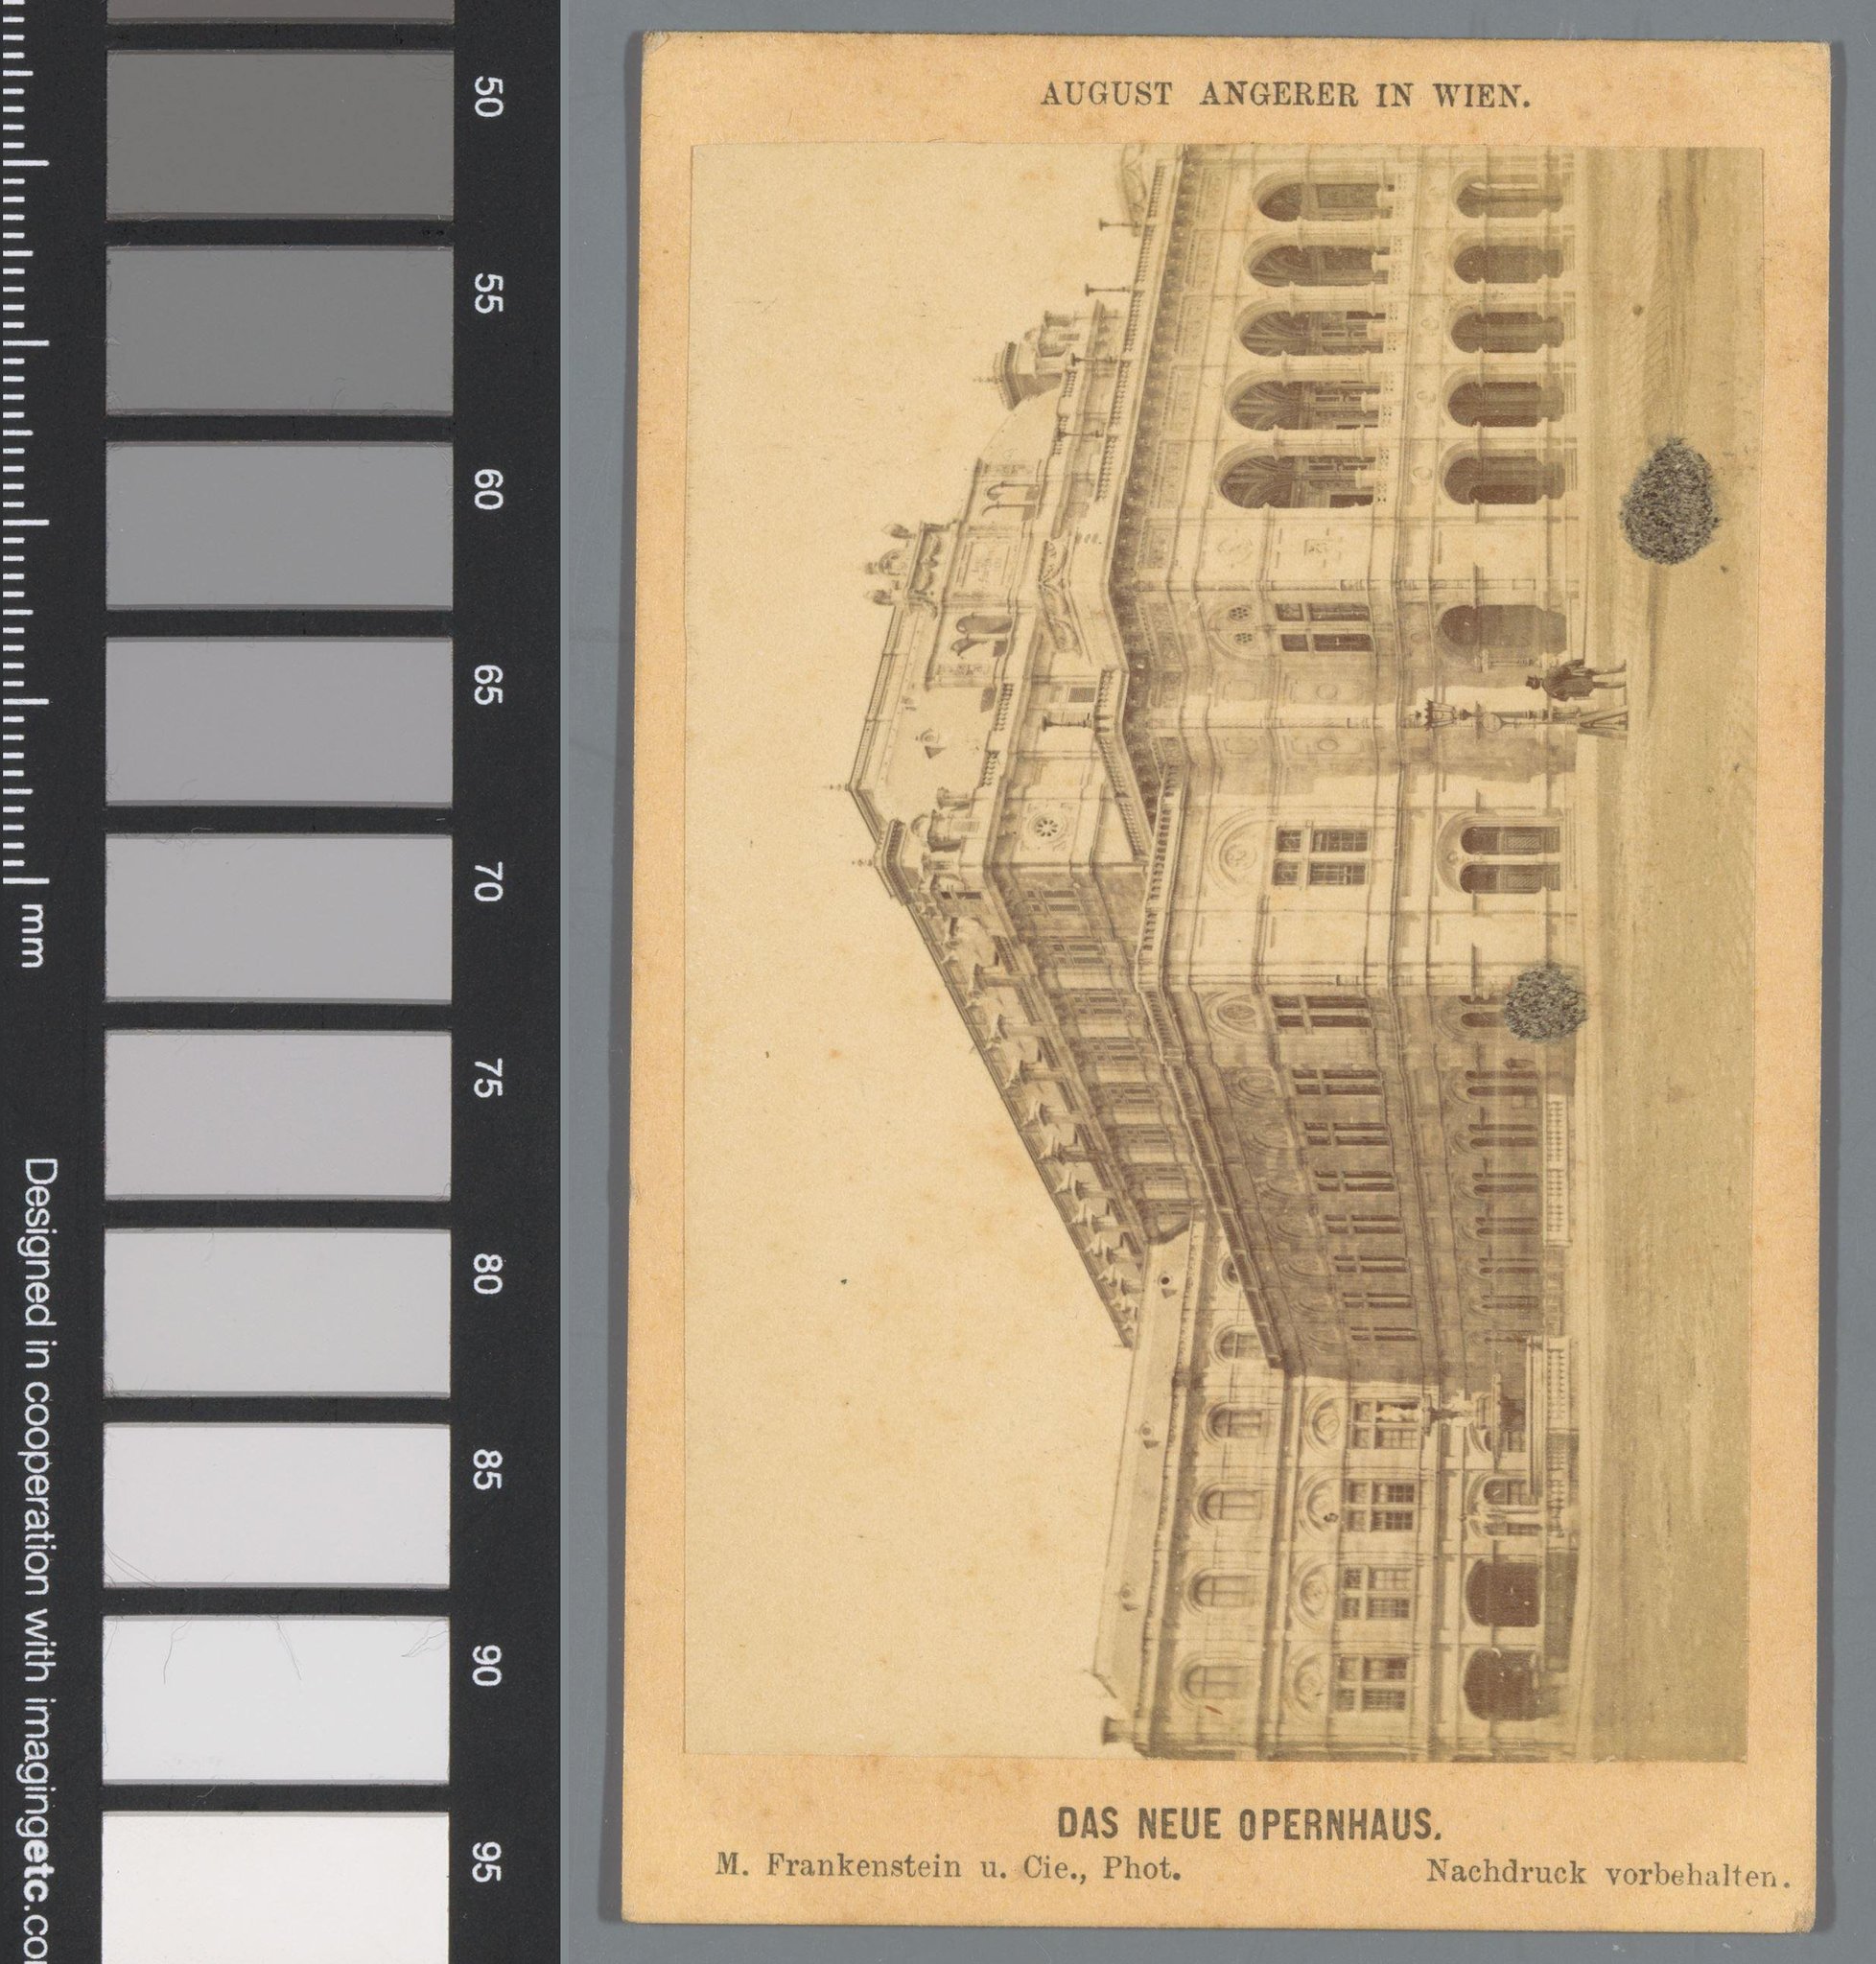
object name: carte de visite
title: Das Neue Opernhaus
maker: august angerer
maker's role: publisher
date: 1869-1880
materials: cardboard, paper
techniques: albumen print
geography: vienna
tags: opera house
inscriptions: inscription: ‘Nachdruck vorbehalten.’, inscription: ‘Opera./ Wenen’